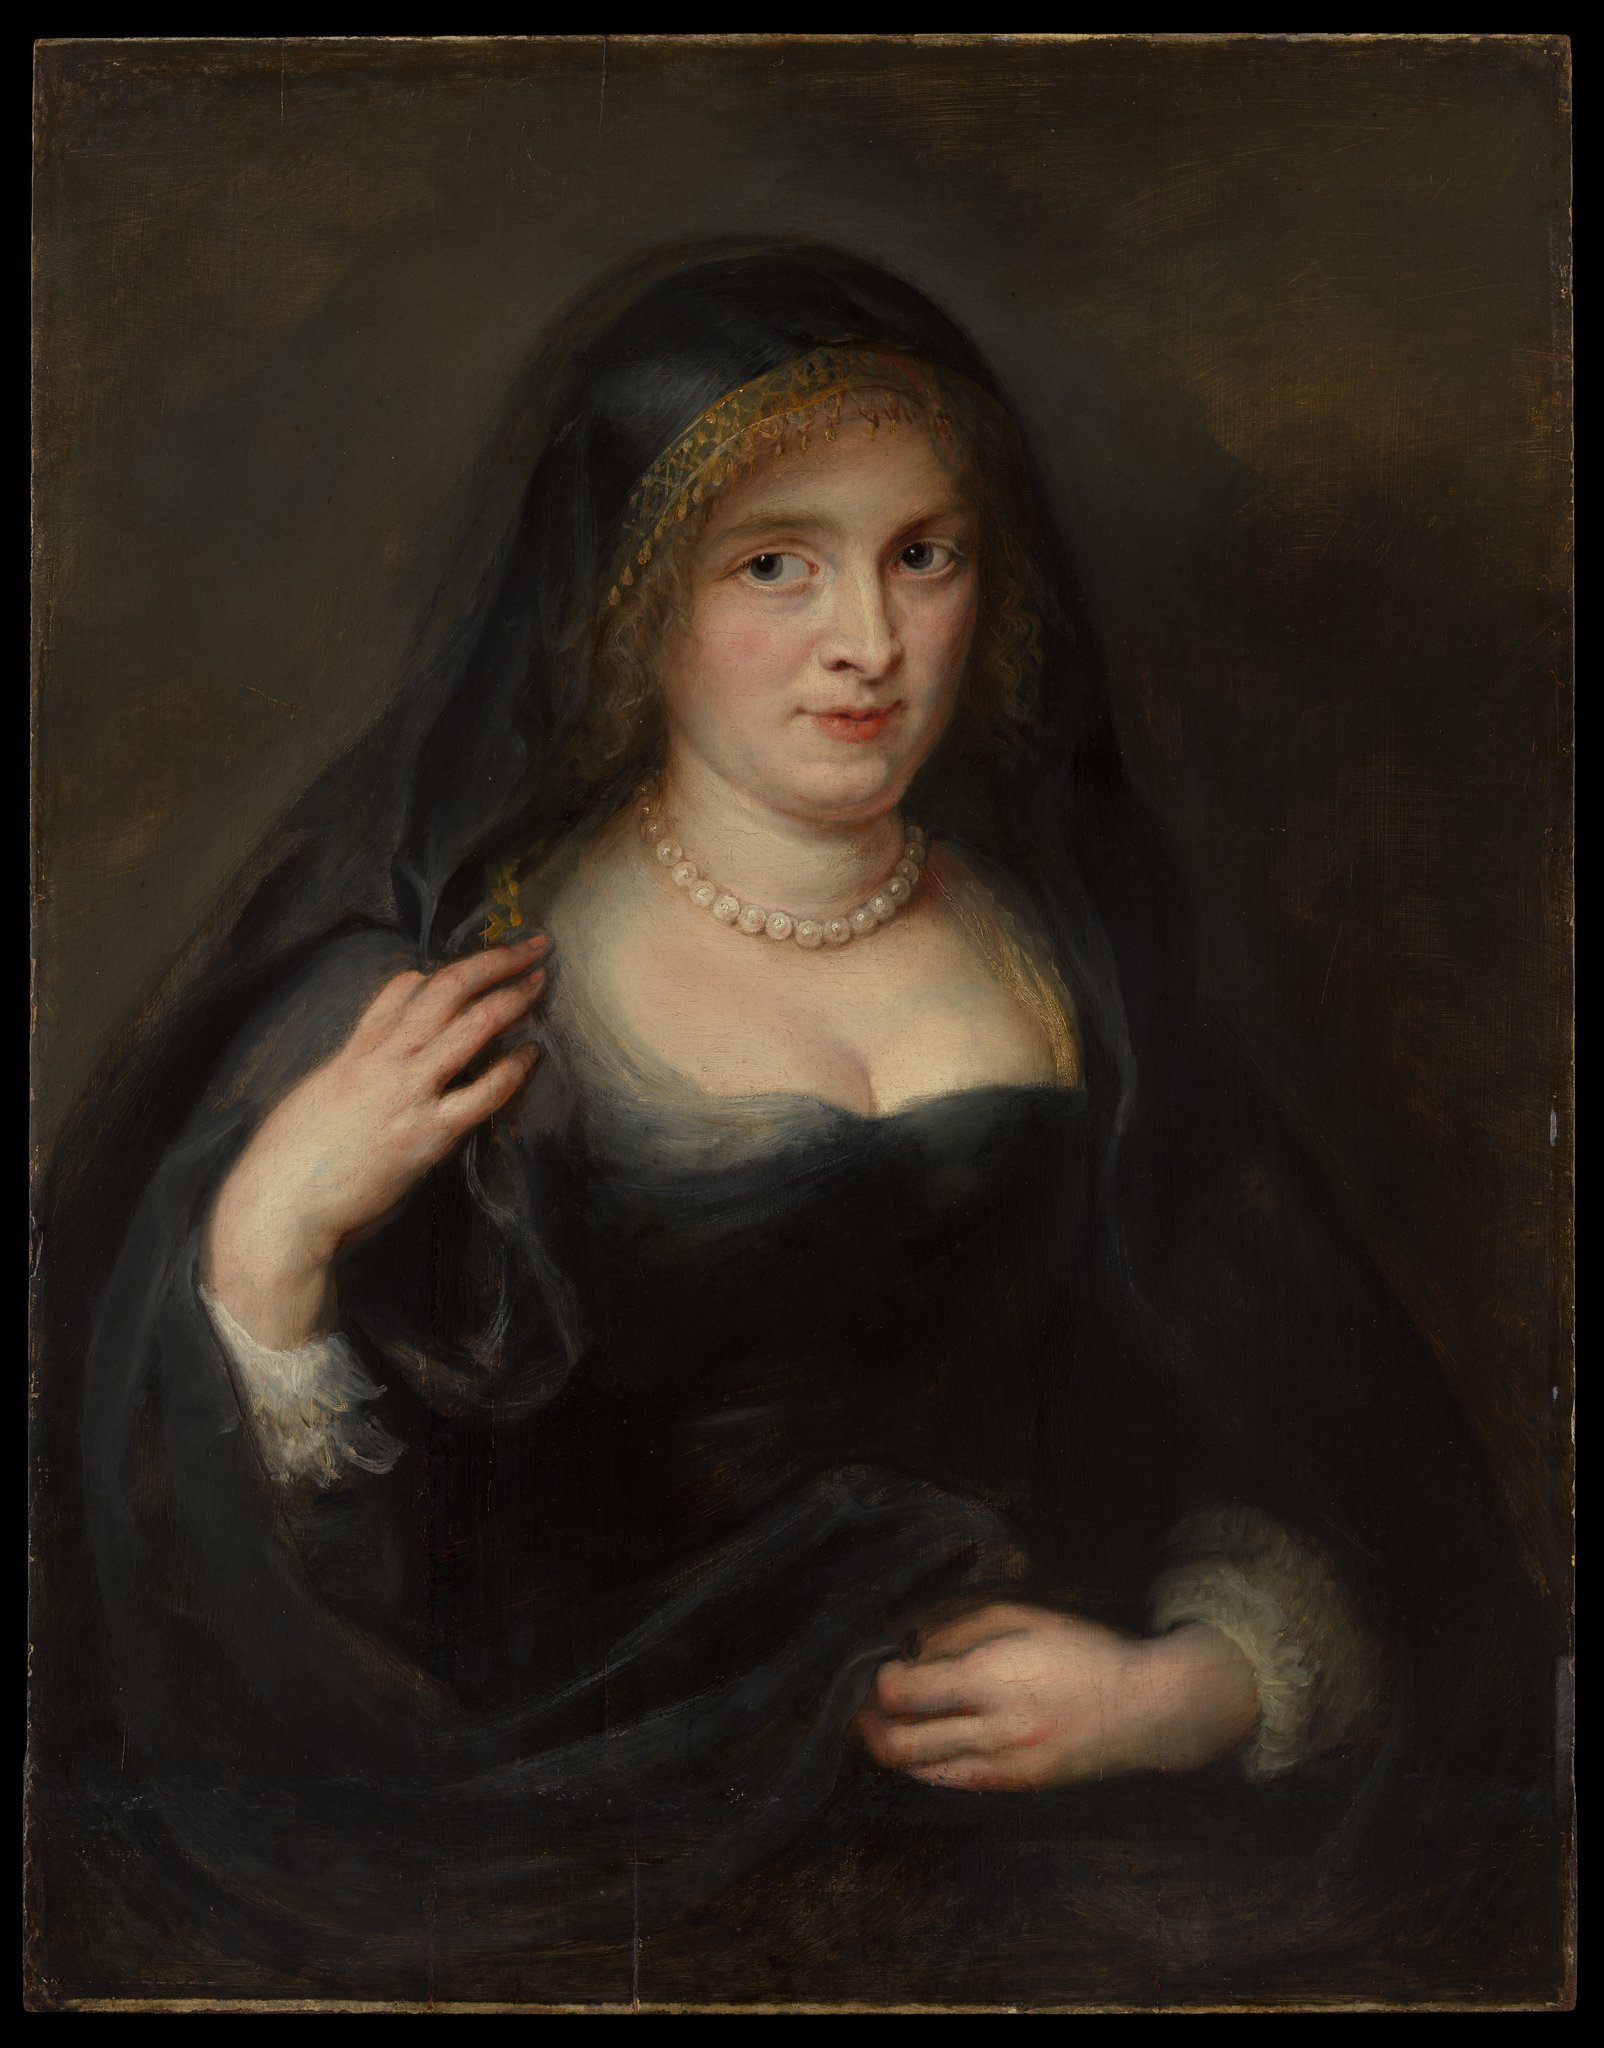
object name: painting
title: Portrait of a Woman, Probably Susanna Lunden (Susanna Fourment, 1599–1628)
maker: peter paul rubens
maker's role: artist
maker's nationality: flemish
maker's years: 1577-1640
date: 1625-1627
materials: oil, wood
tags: portraits,women